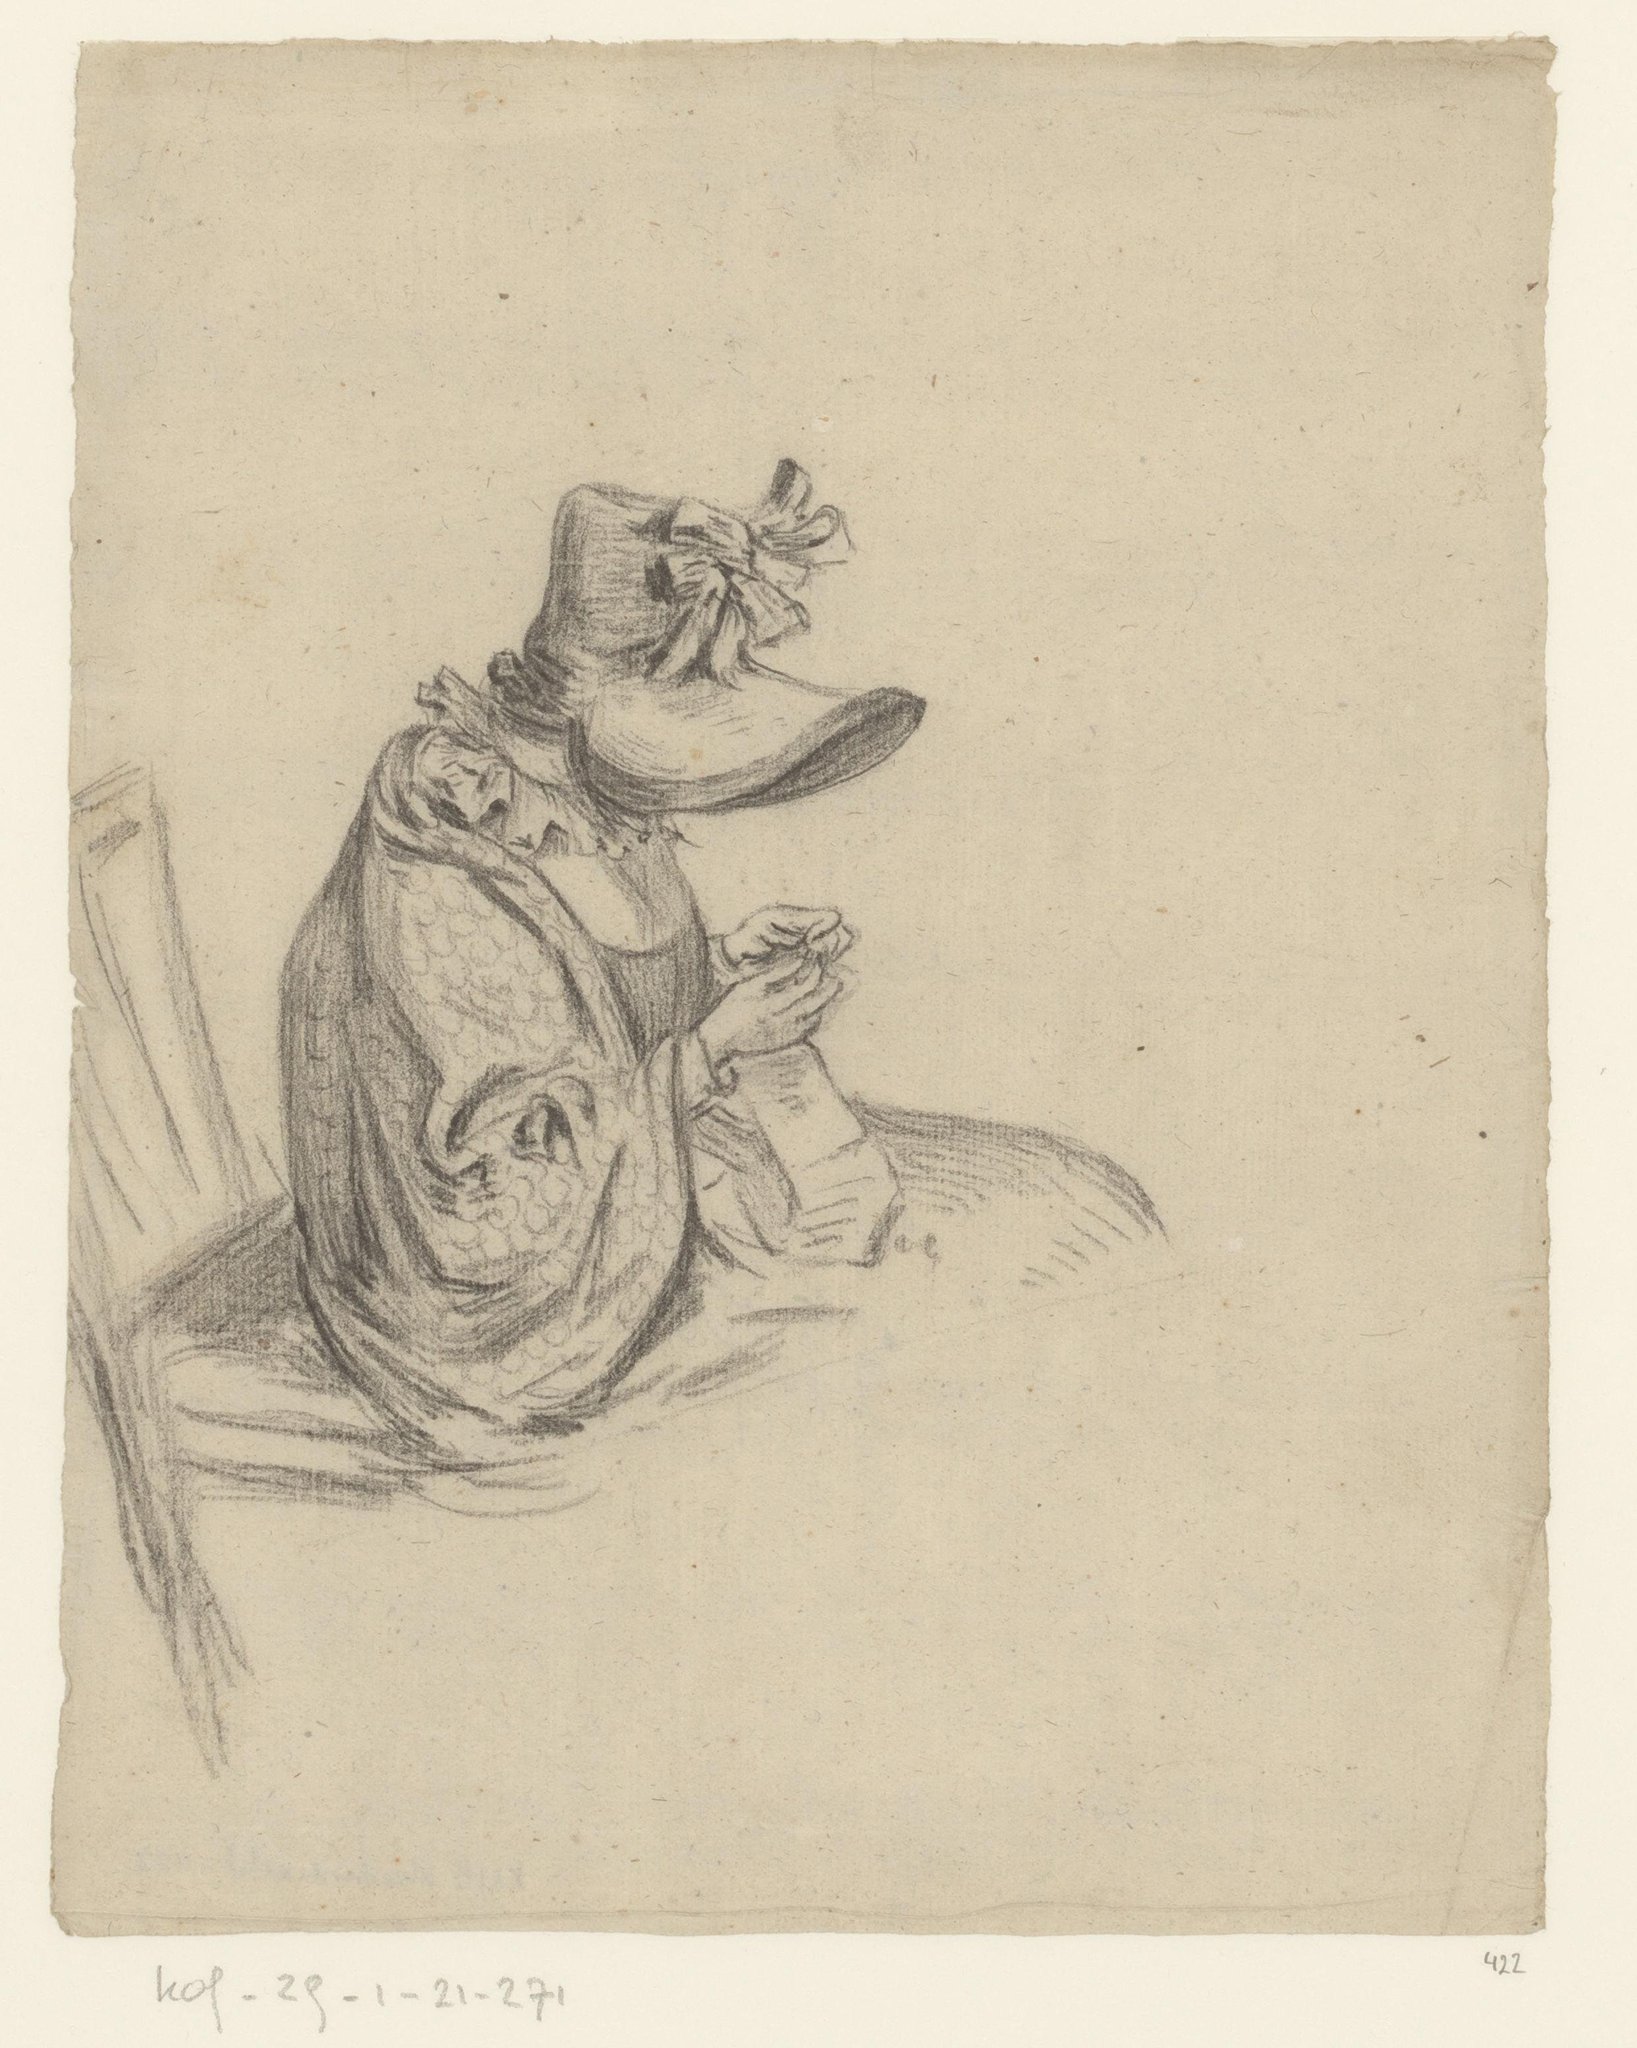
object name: drawing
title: Zittende vrouw met luifelhoed breidt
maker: jean bernard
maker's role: draughtsman, print maker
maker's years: 1765-1833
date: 1775-1833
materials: chalk, paper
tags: head-gear: cap, sitting on an elevation - aa - female human figure, sewing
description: Onderwerpsrubrieken binnen de Atlas Zeden en Gewoonten: Zeden en Gewoonten in Engeren Zin, De Kleeding, Kleederdrachten (tijdvakken), De regeering van Willem I. Mannen en vrouwen.